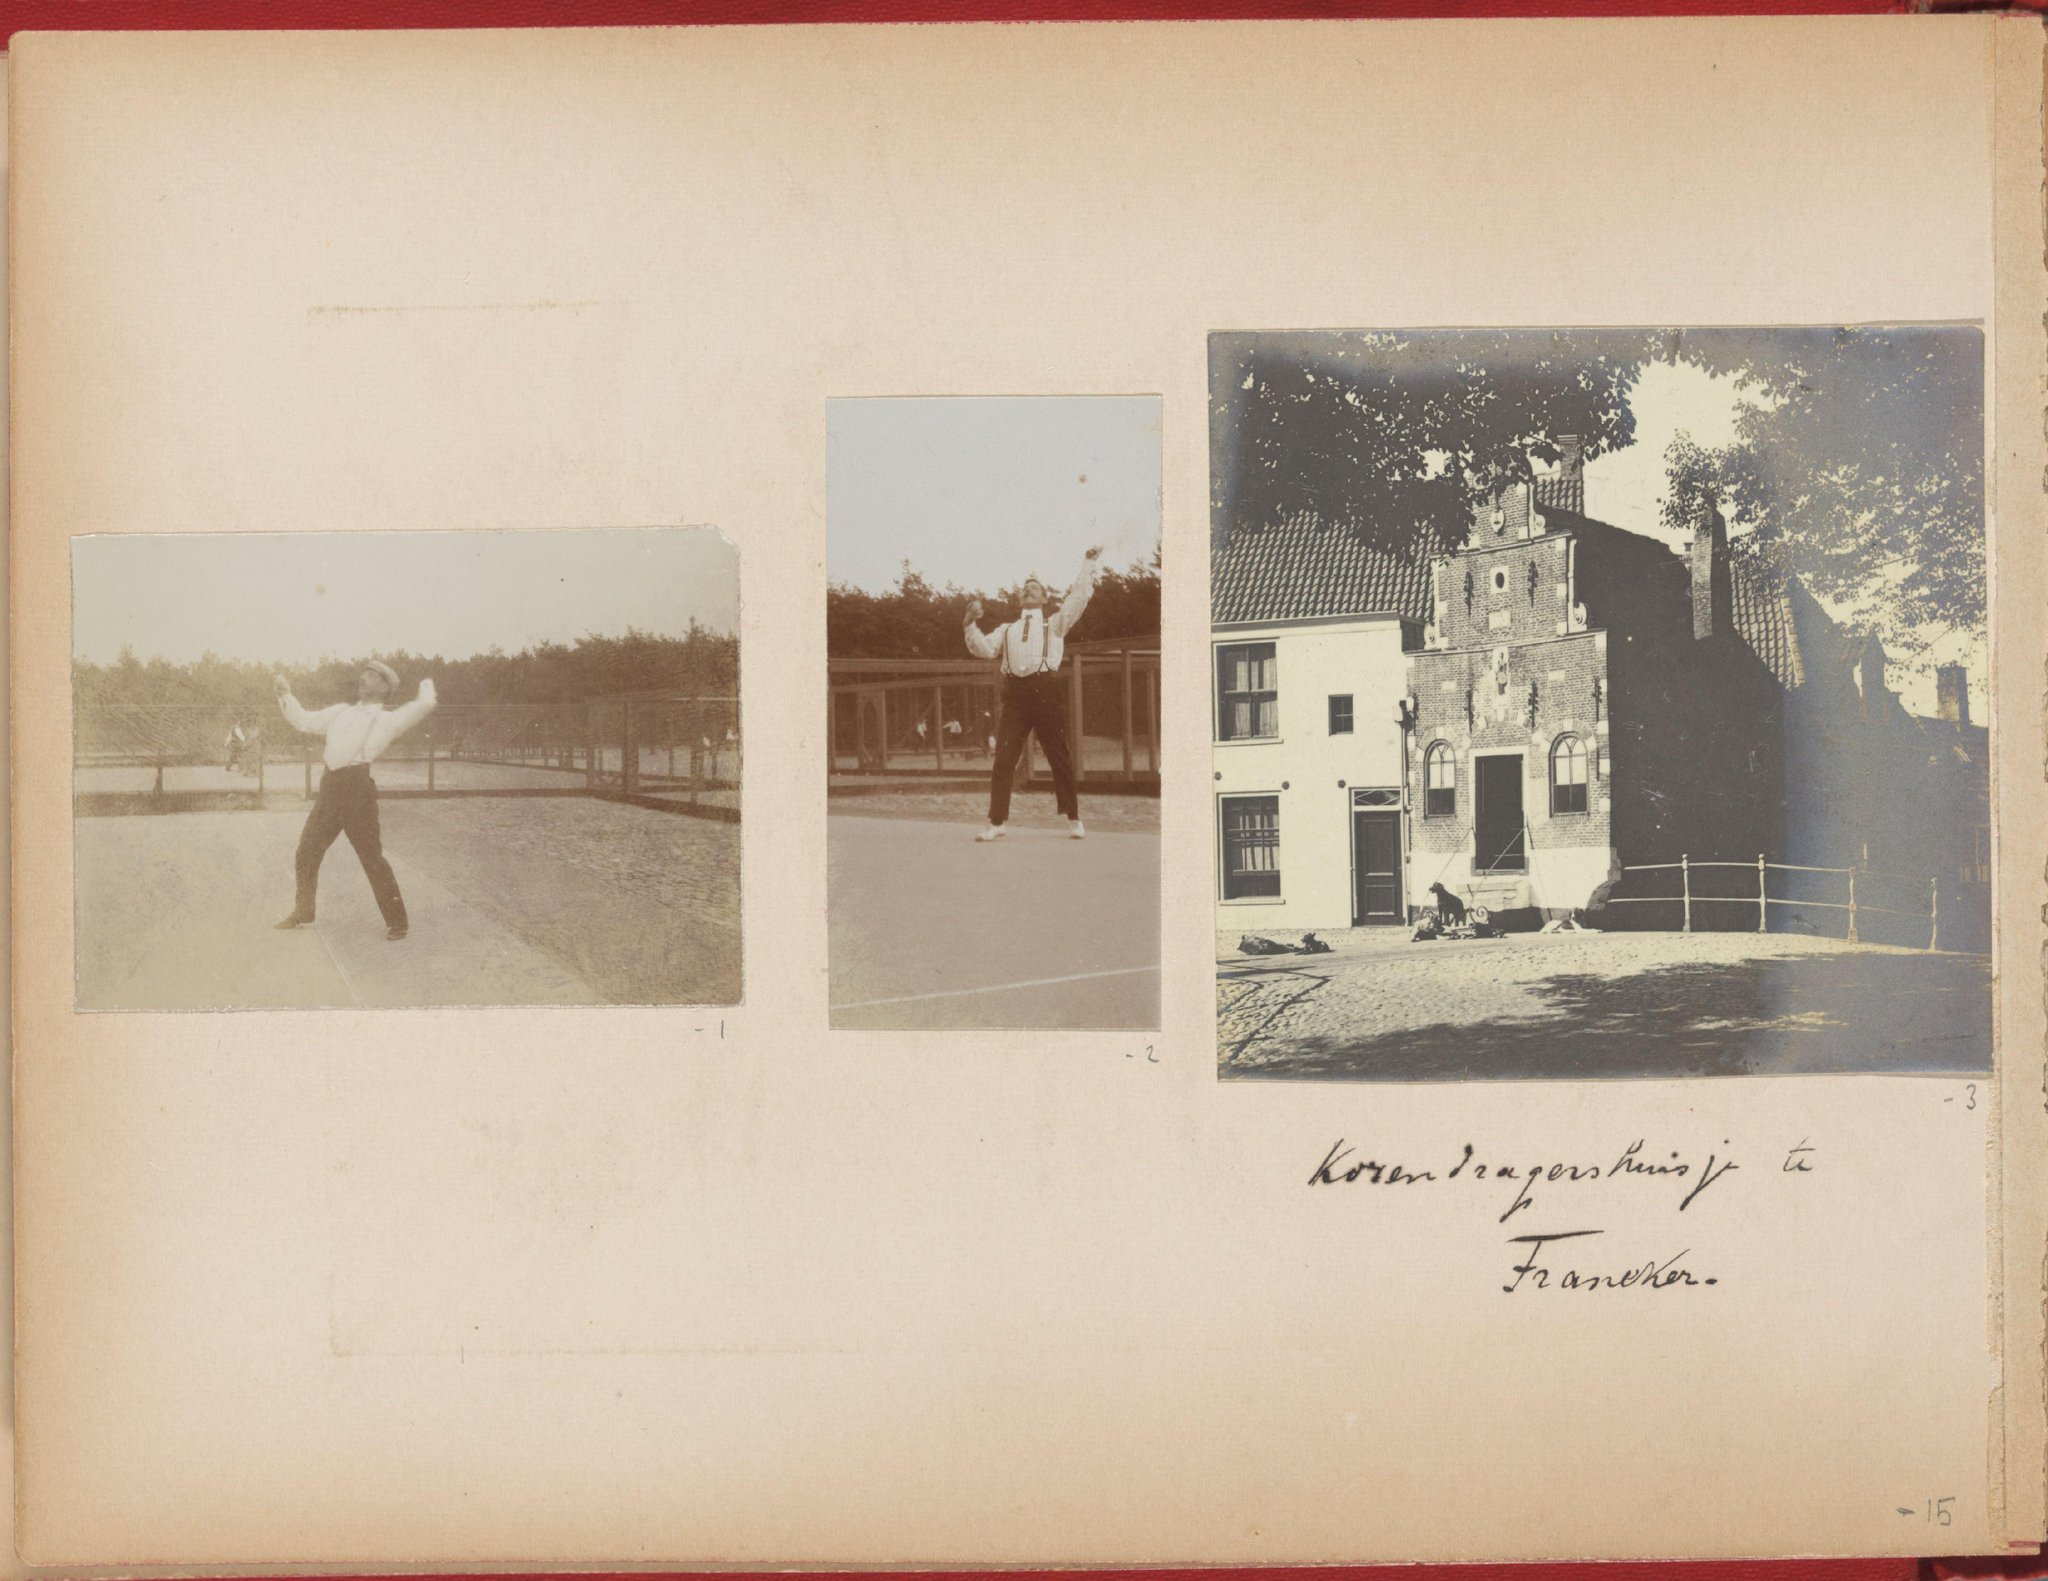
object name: photograph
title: Het Korendragershuisje te Franeker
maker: gerard aalbersberg (us)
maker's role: amateurfotograaf, arts, chirurg, gynaecoloog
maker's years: 1870-1934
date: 1899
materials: cardboard, paper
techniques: gelatin silver print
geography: franeker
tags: franeker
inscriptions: title: ‘Korendragershuisje te Franeker’